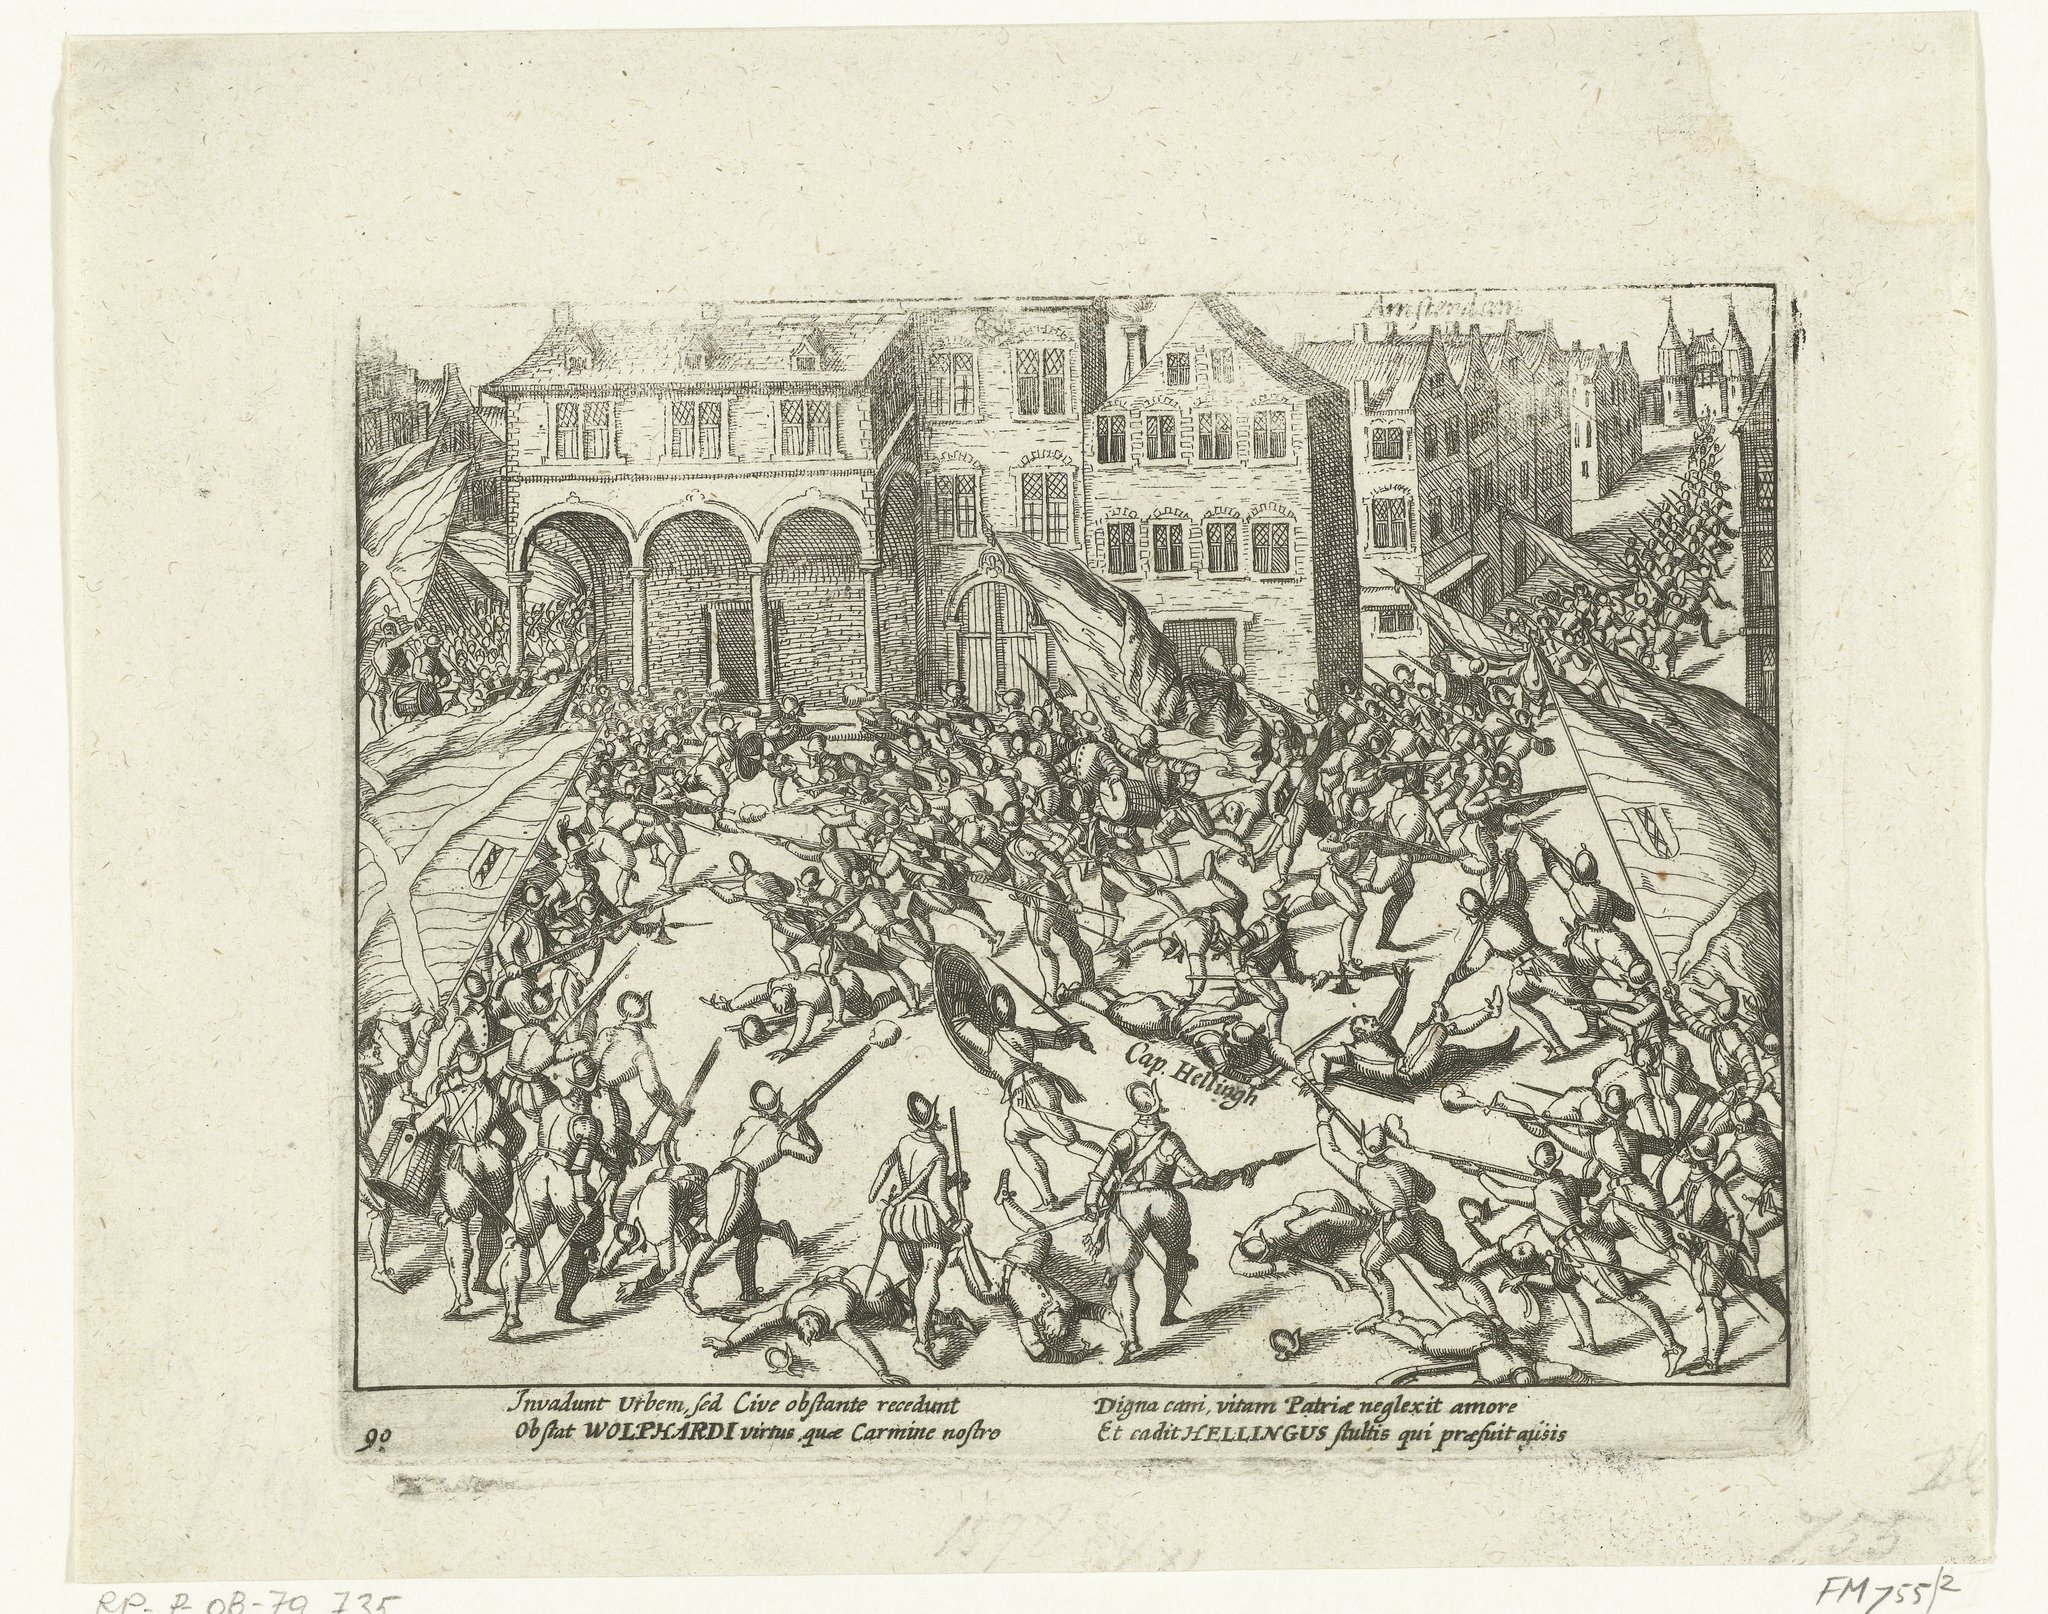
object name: history print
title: Staatse troep verslagen op de Dam, 1577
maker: Anonymous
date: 1613-1615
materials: paper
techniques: etching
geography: netherlands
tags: battle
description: De Staatse troepen onder bevel van Helling en Ruychaver worden bij felle gevechten op de Dam door de Amsterdammers verslagen. Helling zelf komt hierbij om het leven, 23 november 1577. Met onderschrift van 4 regels in het Latijn. Genummerd: 90. Onbedrukt op achterzijde.